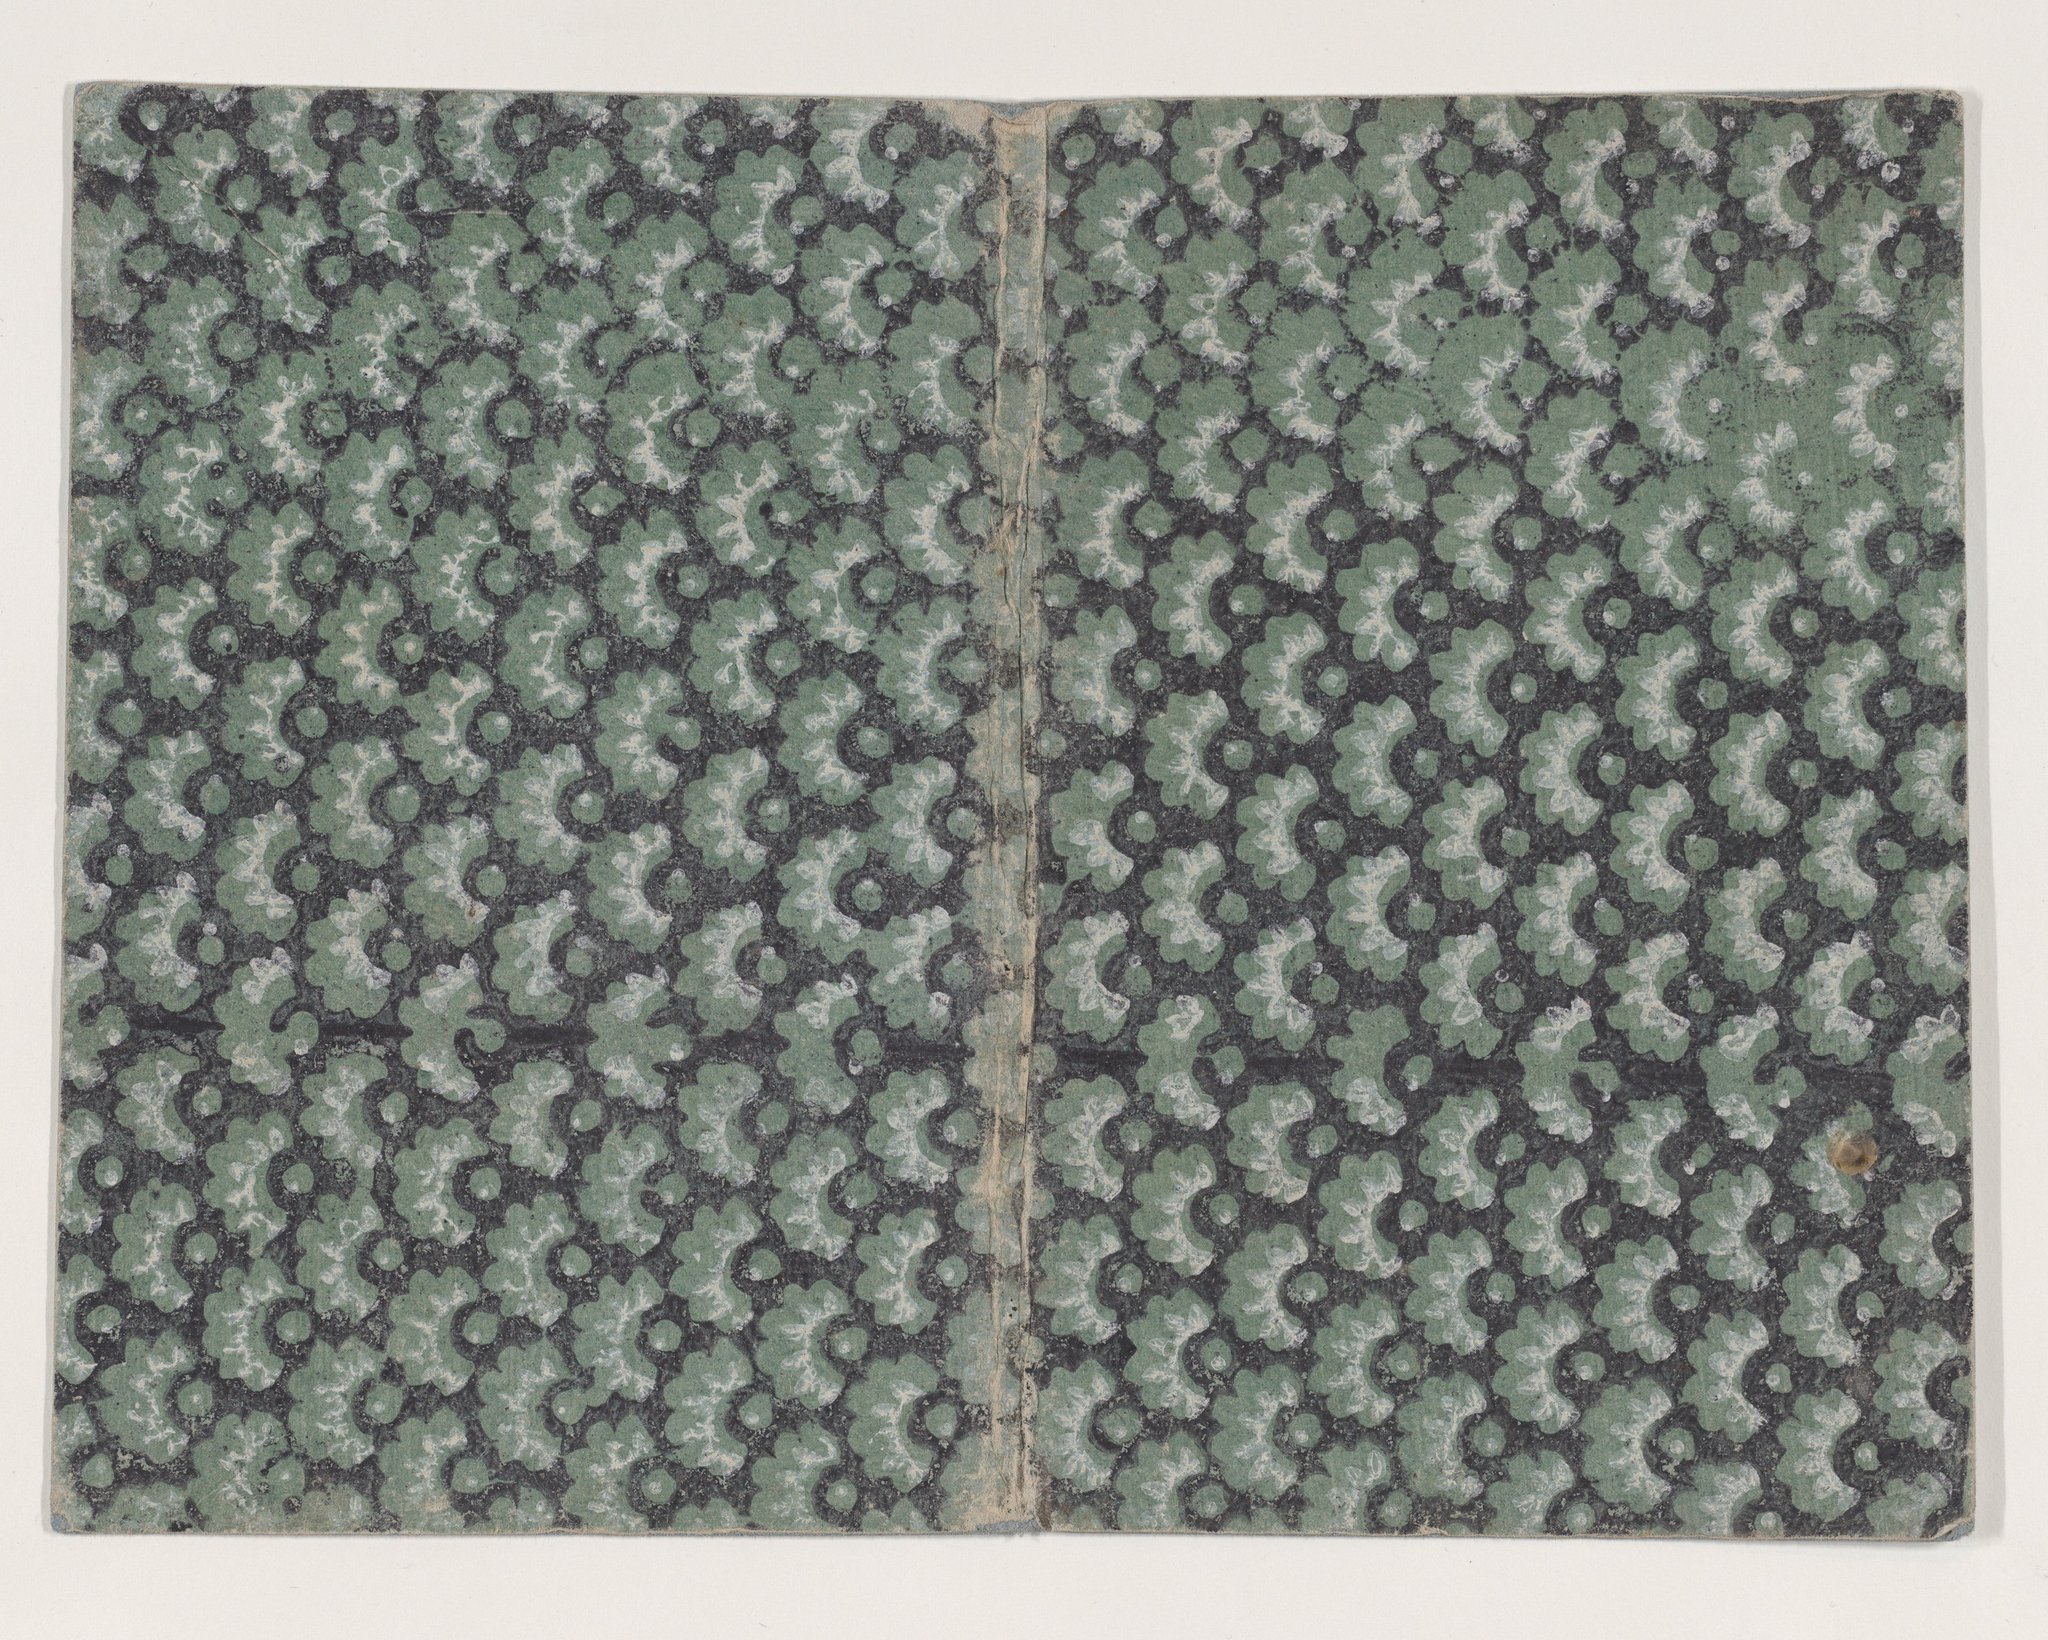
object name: print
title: Book cover with overall green and black abstract pattern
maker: Anonymous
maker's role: artist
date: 1801-1900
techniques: relief print